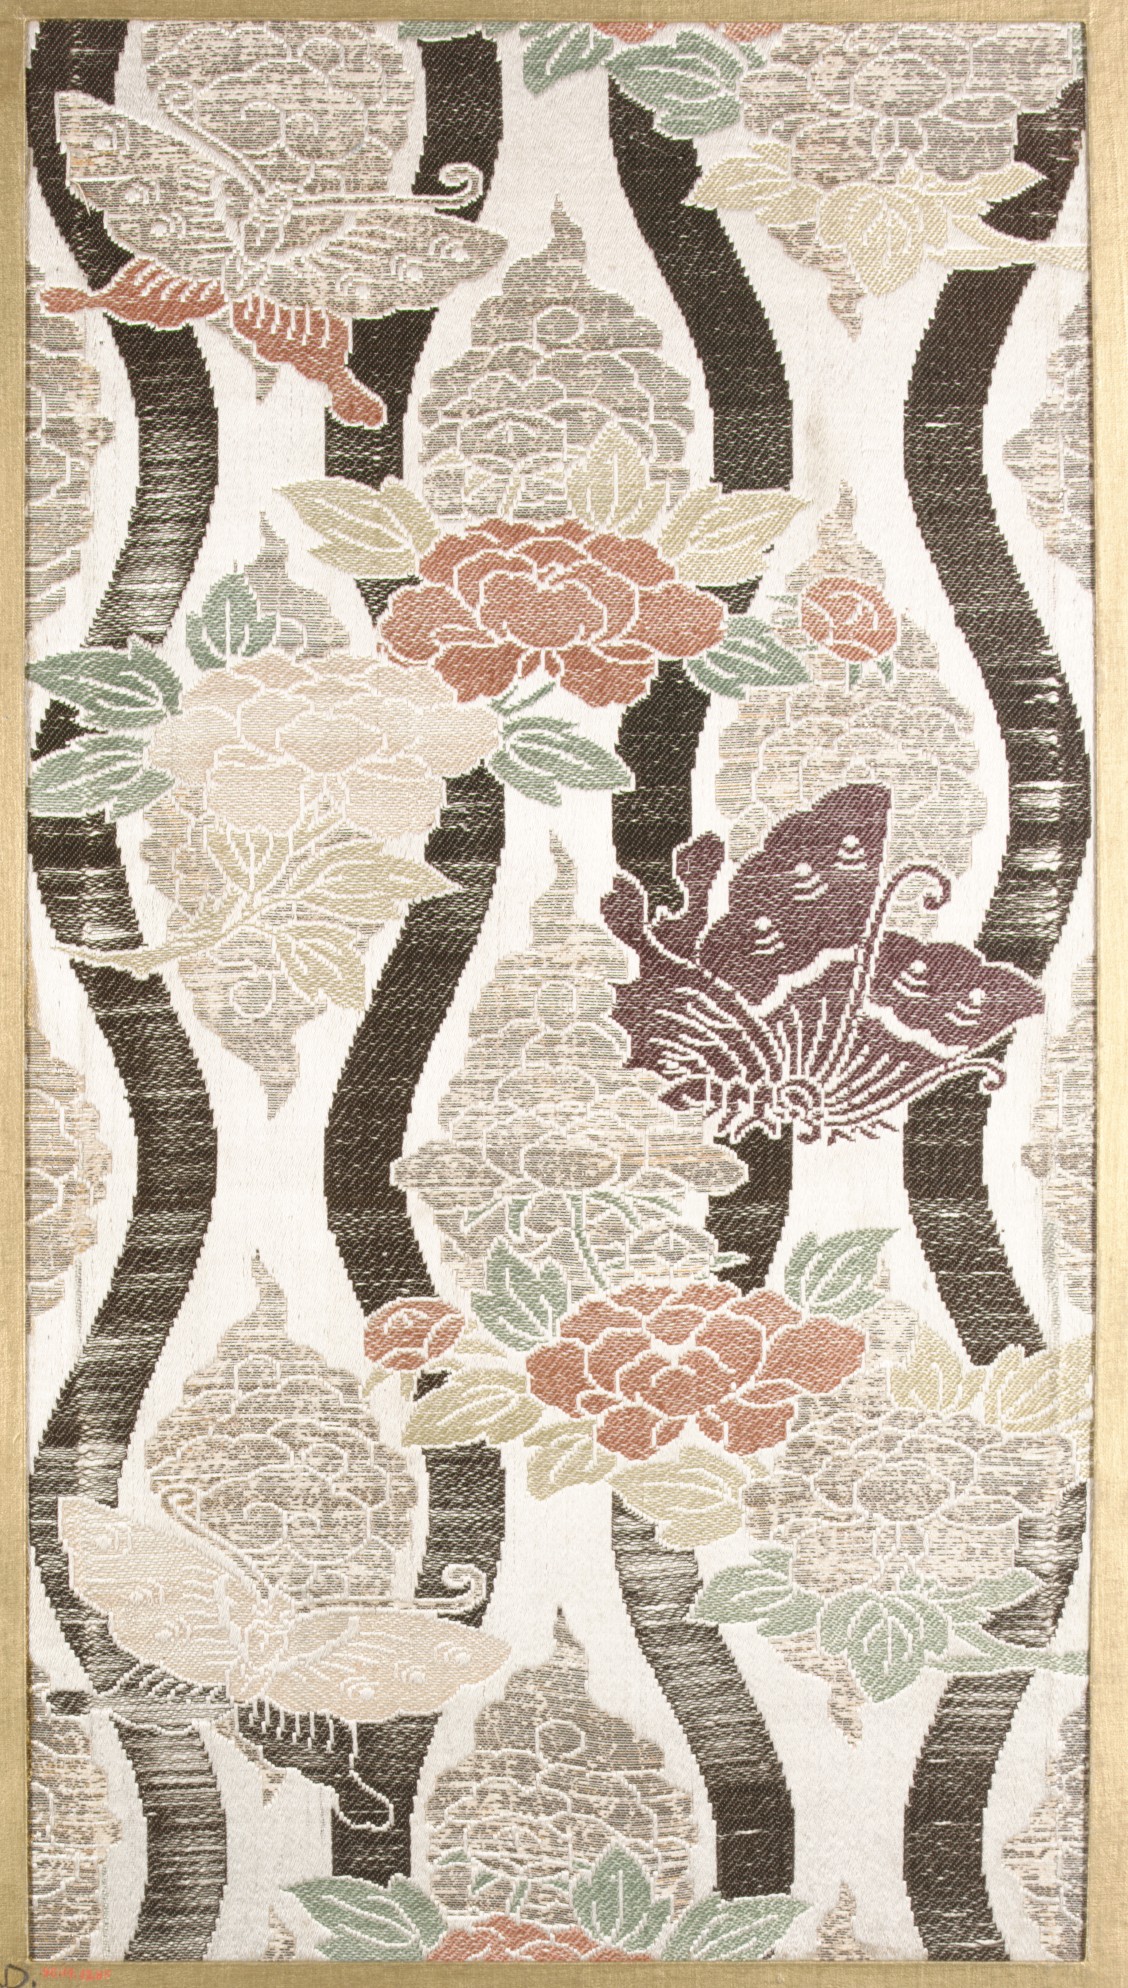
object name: piece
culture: japanese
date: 1701-1900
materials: silk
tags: butterflies,leaves